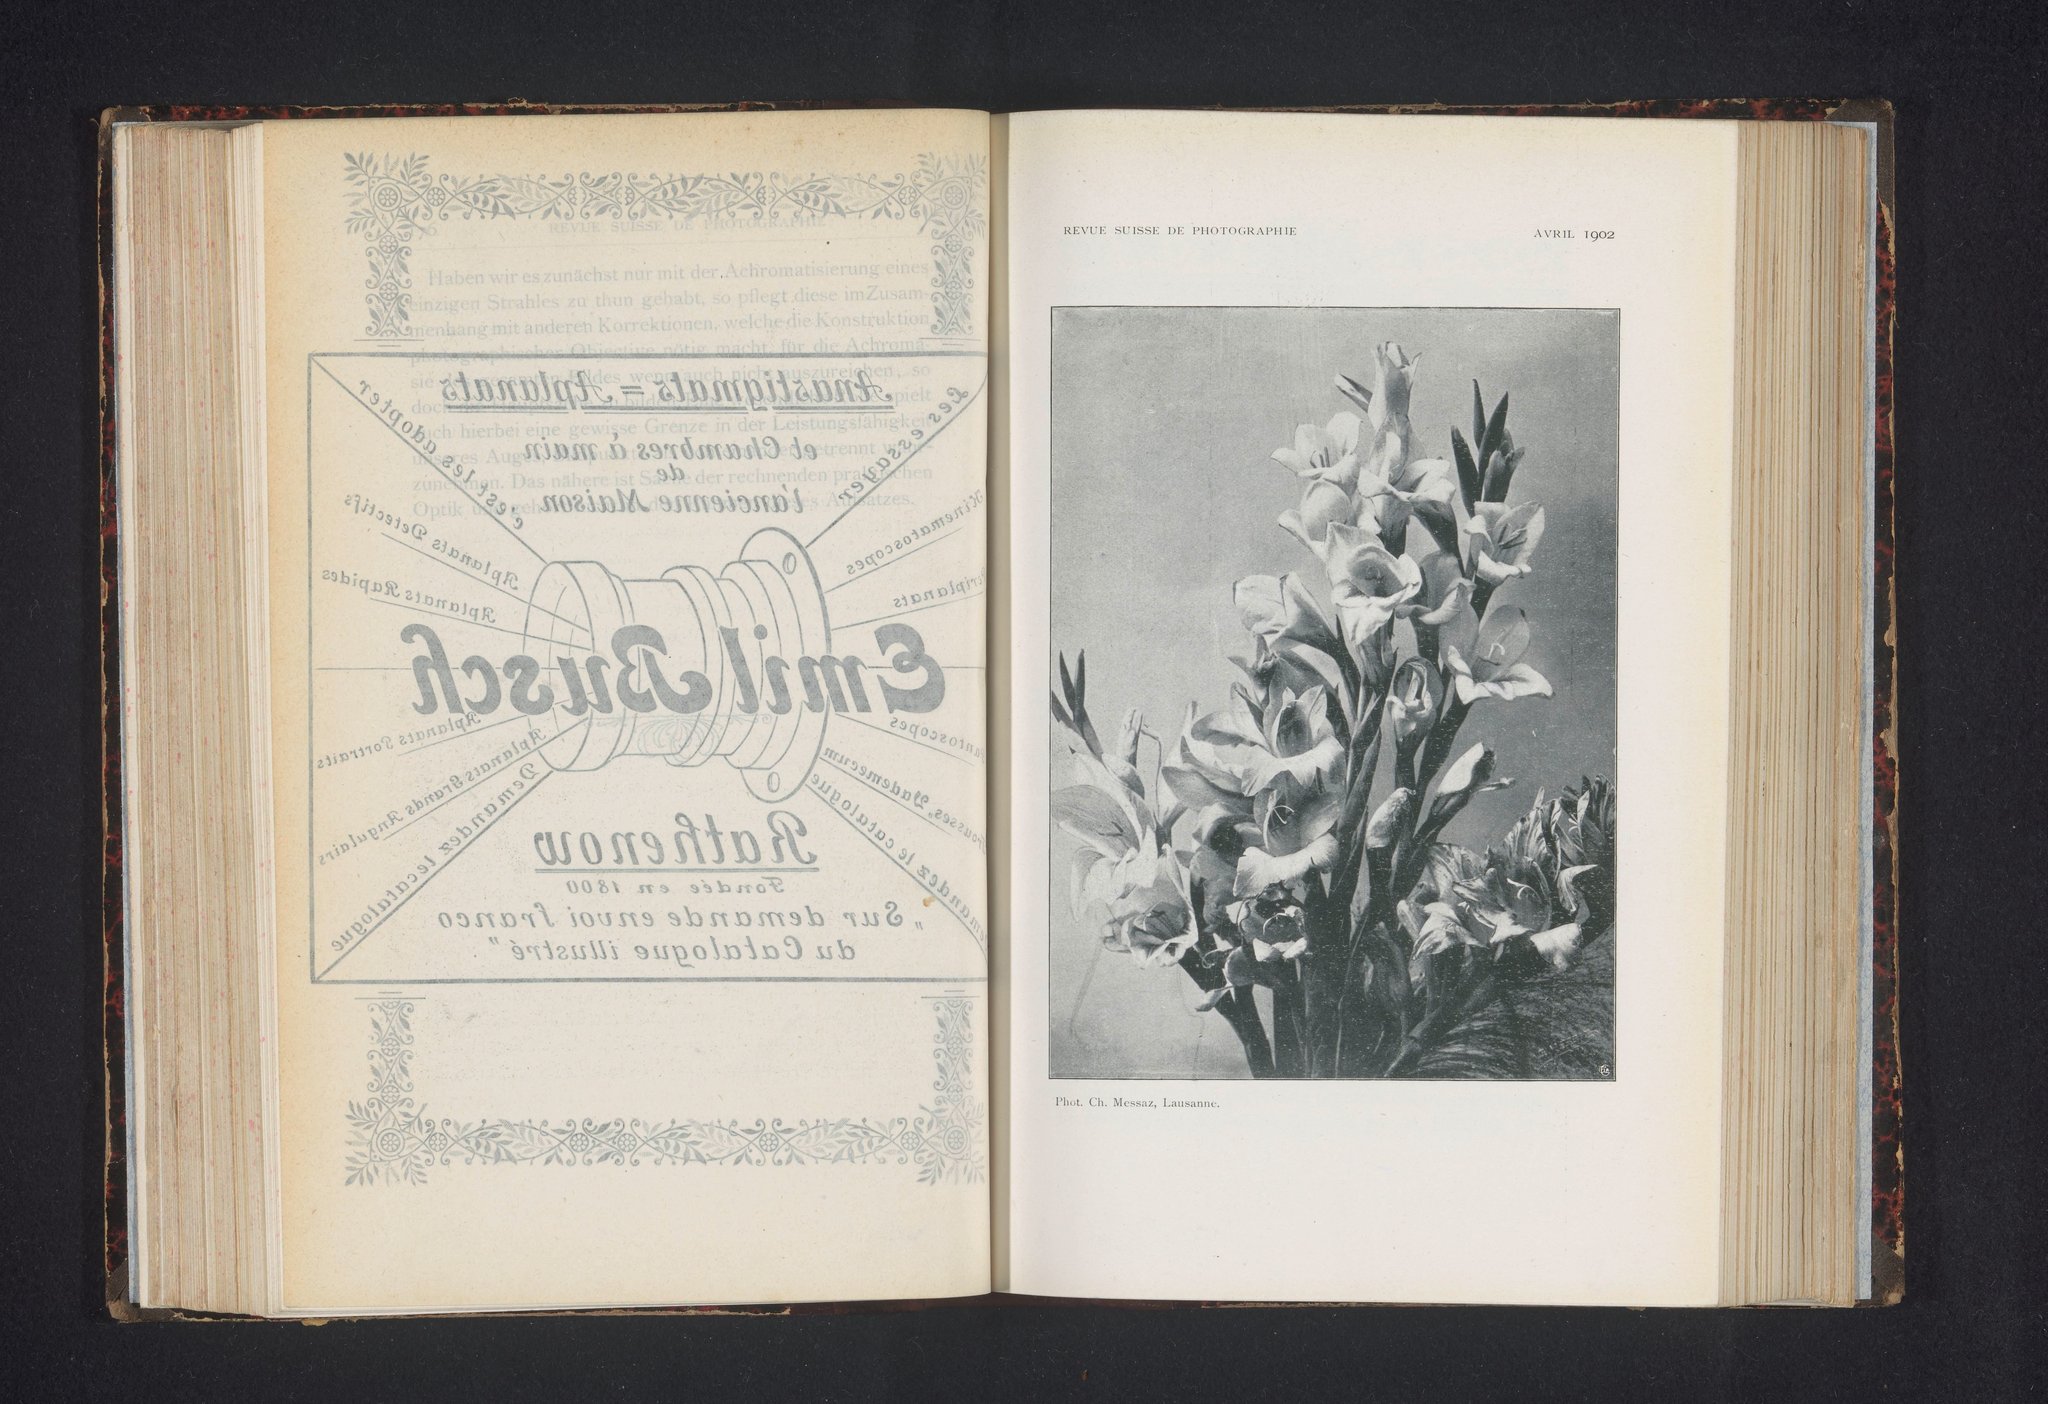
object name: photomechanical print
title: Lelies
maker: charles messaz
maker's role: fotograaf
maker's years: 1866-1928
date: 1897-1902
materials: paper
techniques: autotype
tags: flowers: lily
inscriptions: monogram: ‘C. Cie’, inscription: ‘Revue Suisse de photographie/ Avril 1902’